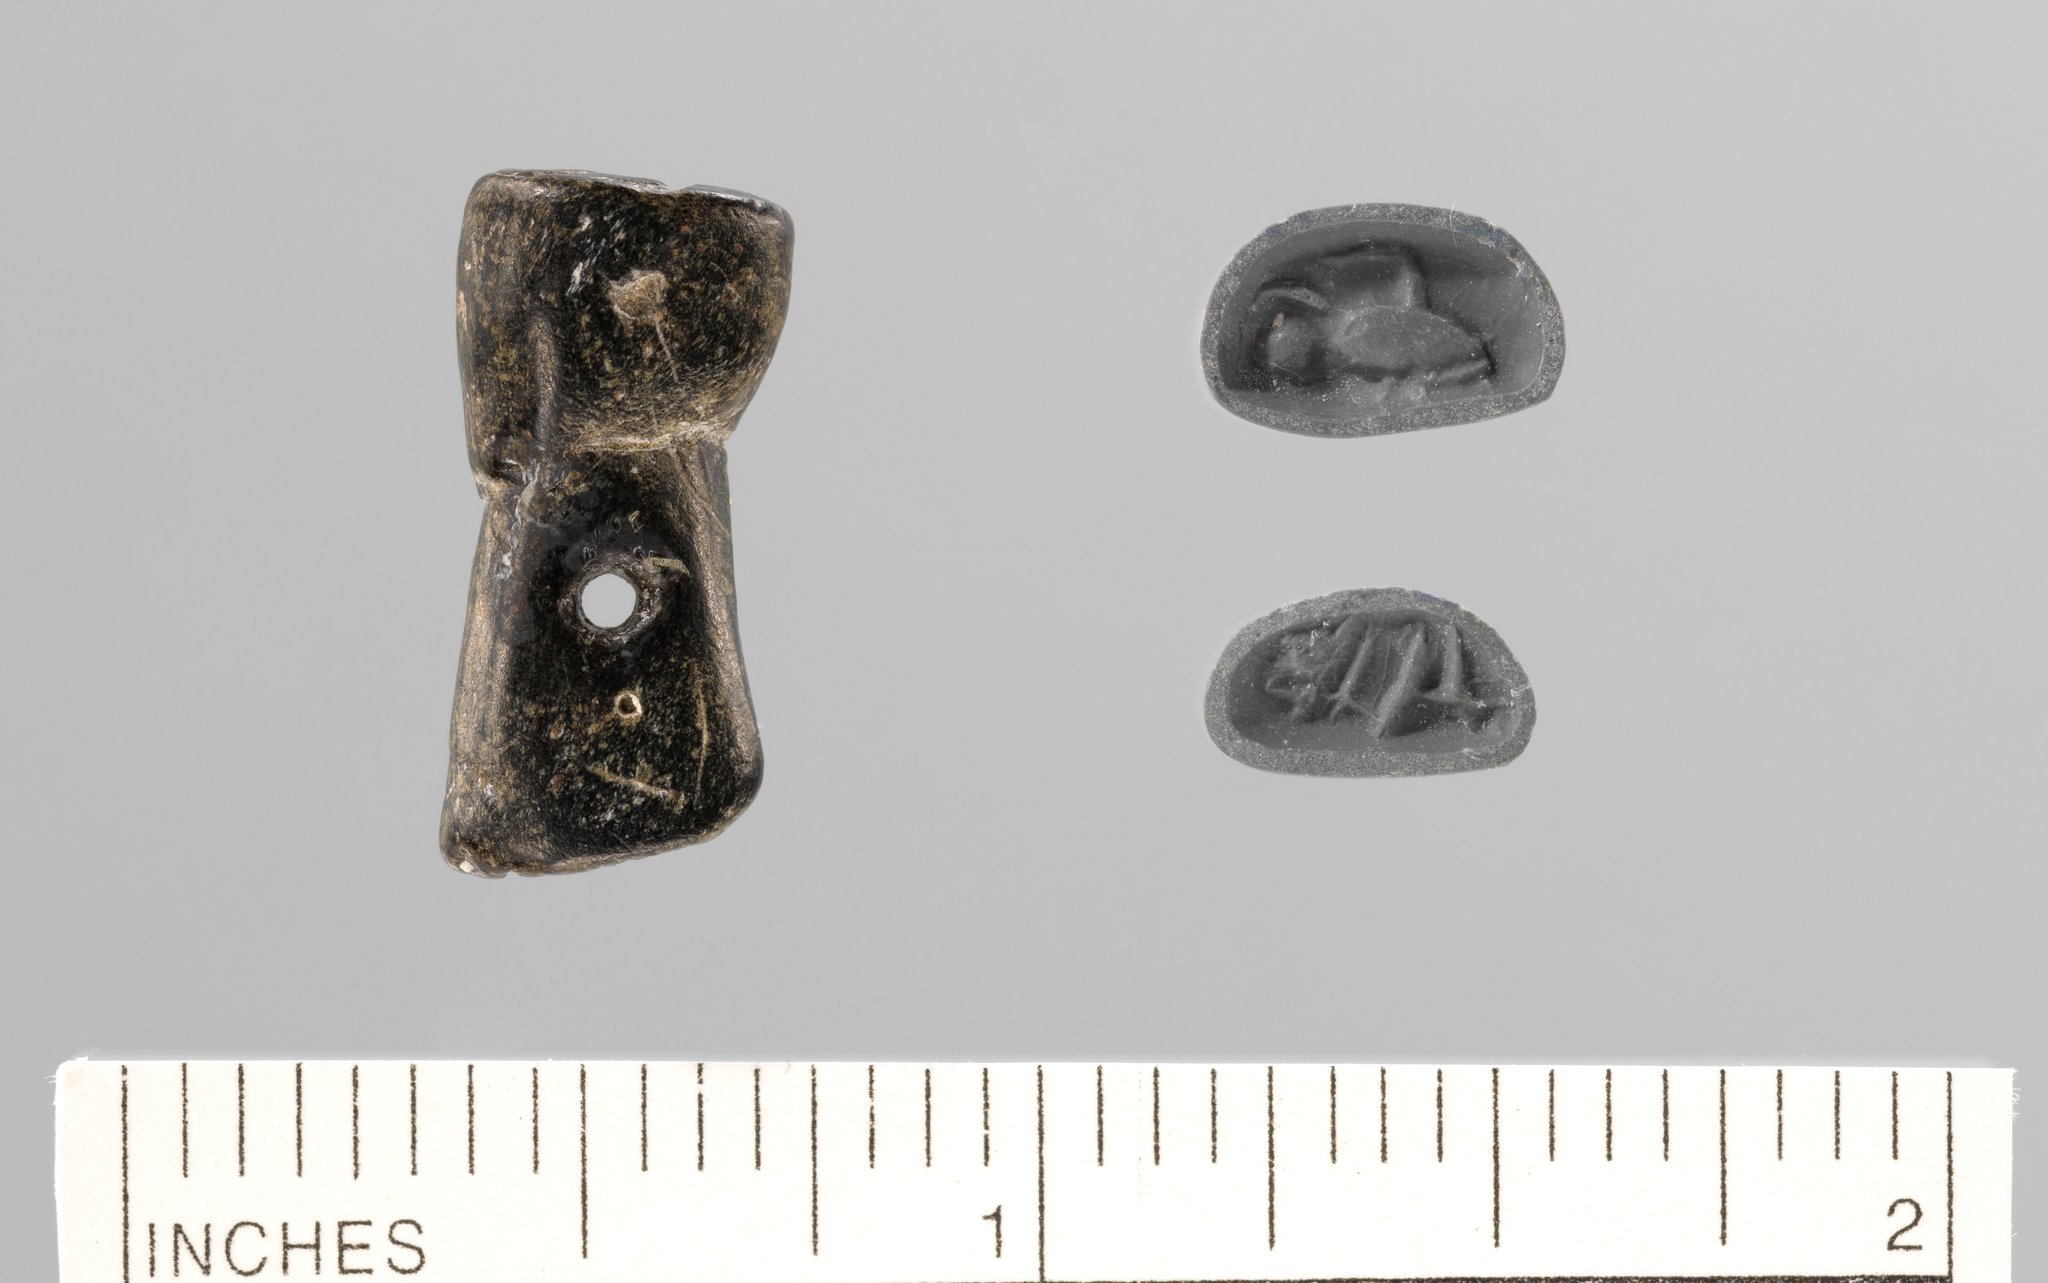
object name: seal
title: Steatite Seal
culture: minoan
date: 1800-1700 BCE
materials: stone